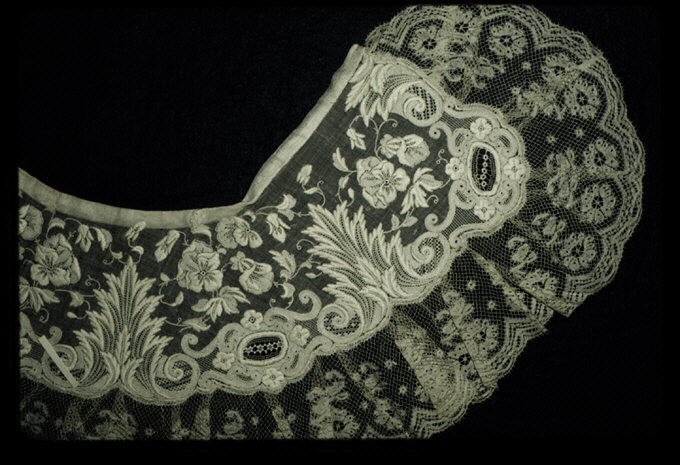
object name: collar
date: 1801-1850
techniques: lace, embroidery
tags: flowers